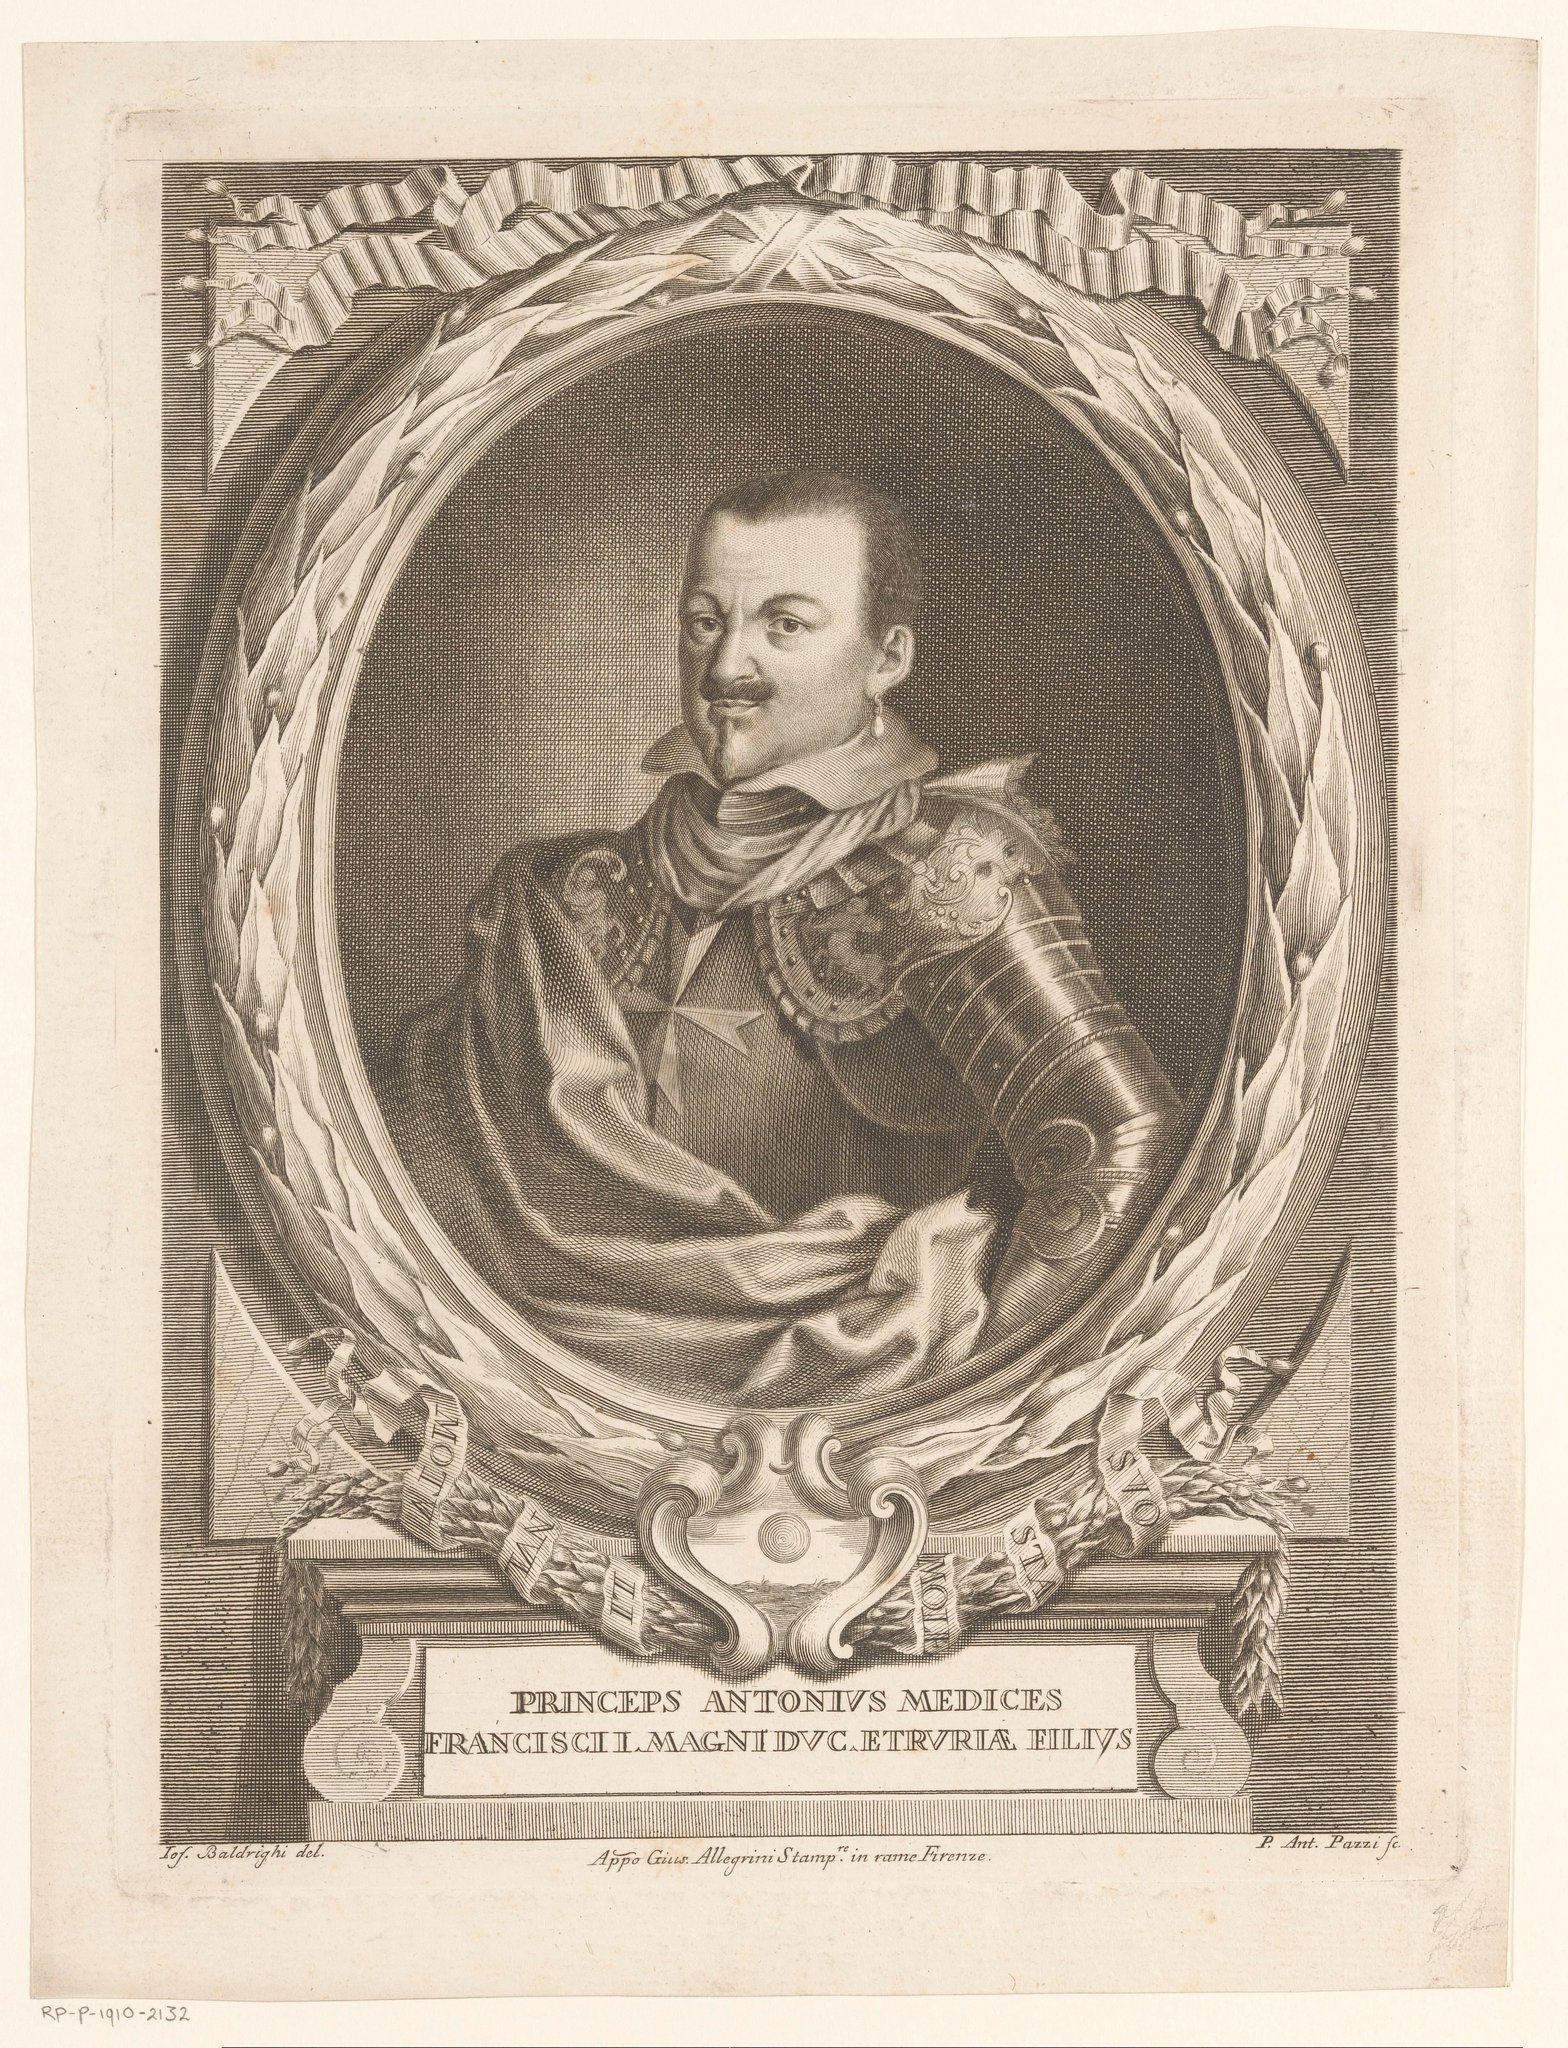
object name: print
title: Portretten van de familie de' Medici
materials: paper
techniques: engraving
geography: florence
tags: historical persons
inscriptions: collector's mark: Lugt 2228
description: Deze prent maakt deel uit van een serie van onbekende omvang met portretten van de familie De' Medici. De ornamentlijst is vergelijkbaar met de ornamentlijsten door Adriaen Haelwegh in een serie van 31 prenten met portretten van de familie De' Medici.